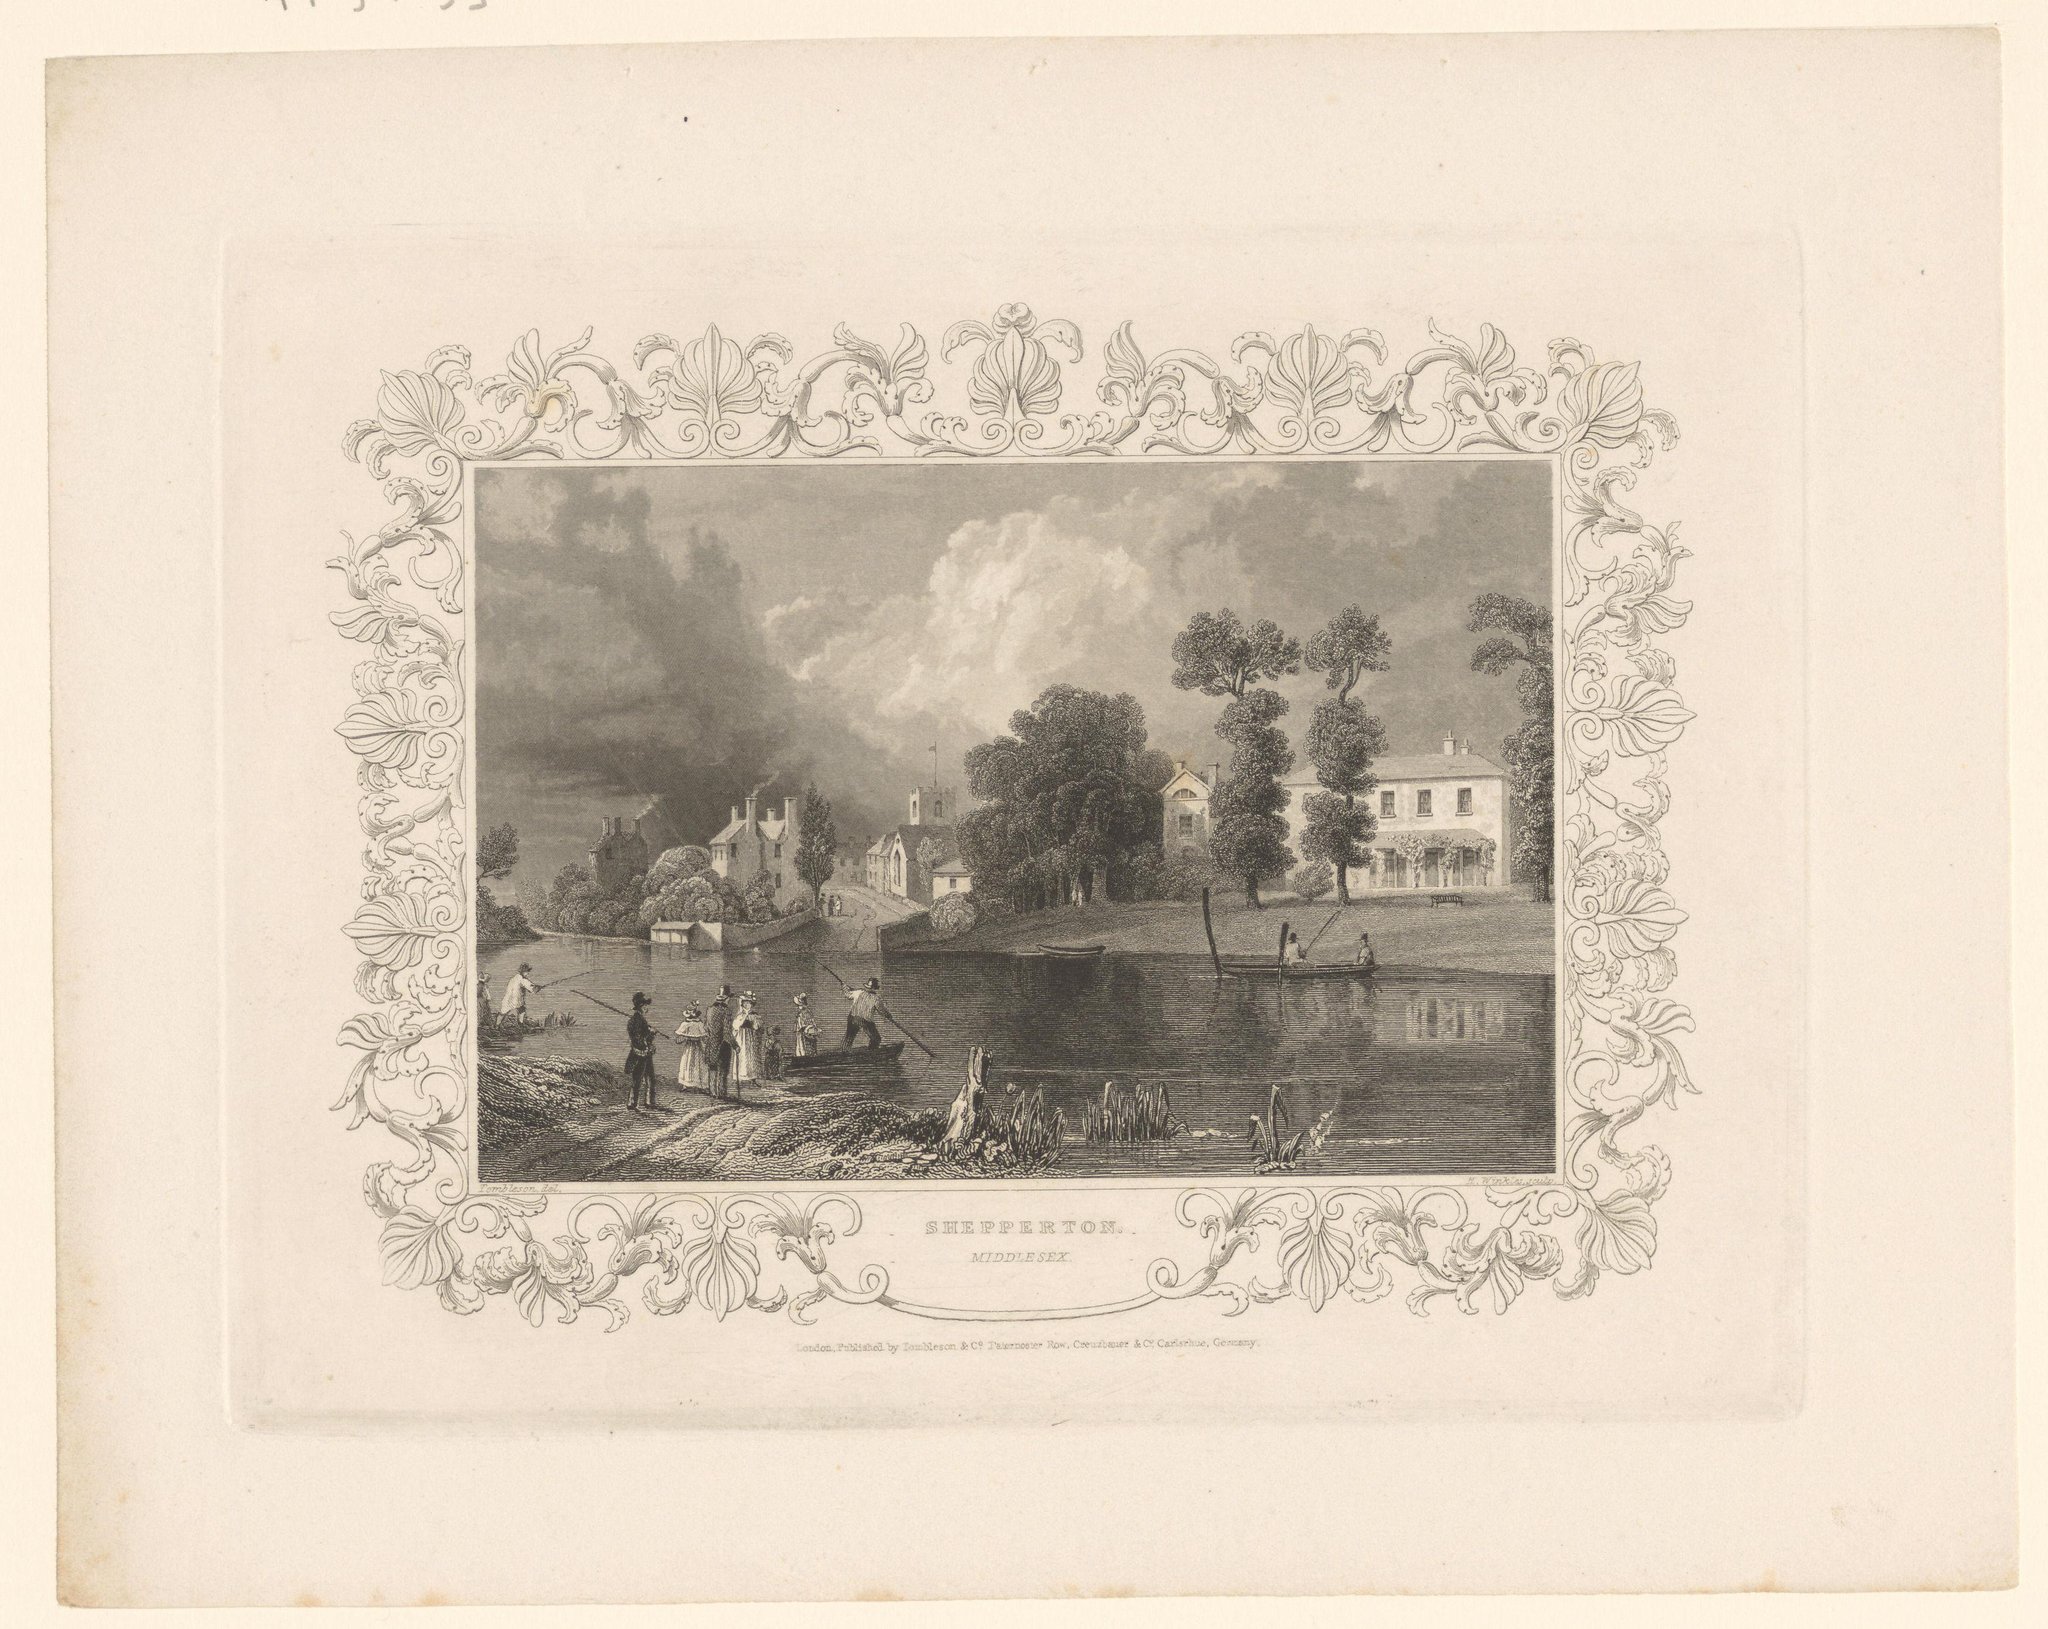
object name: print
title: Shepperton. Middlesex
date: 1831-1837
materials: paper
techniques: etching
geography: london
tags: river, village, rowing-boat, canoe, etc.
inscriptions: collector's mark: Lugt 2228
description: Prent ook gebruikt in: Fearnside, W.G. Eighty Picturesque Views of the Thames and Medway (...). Londen: Black & Armstrong, [ca. 1831-1837].